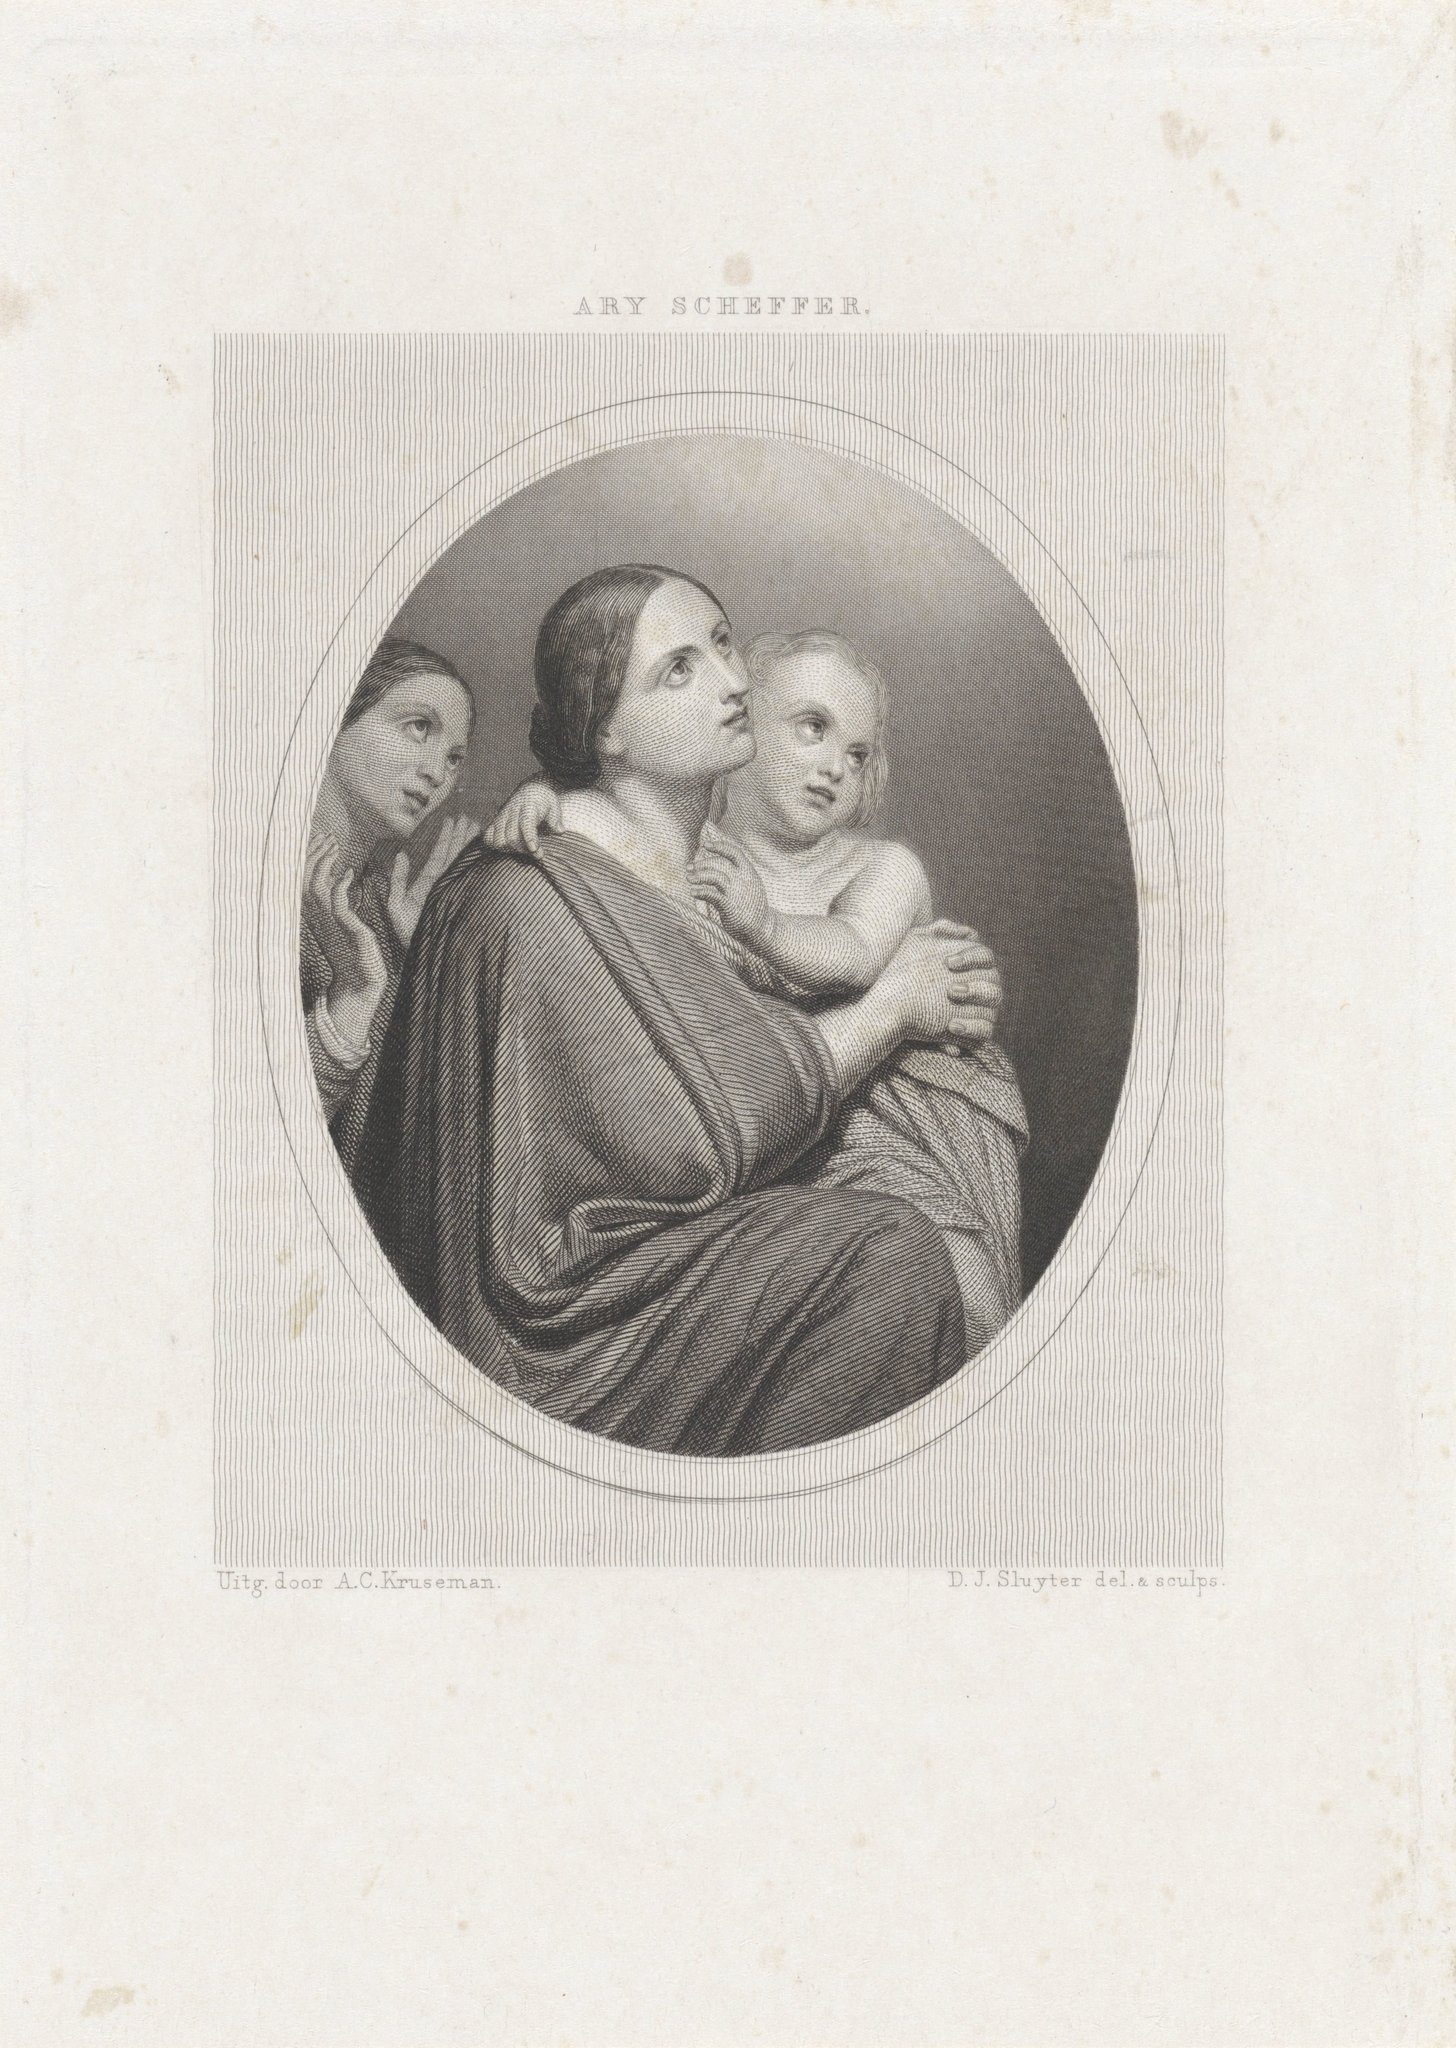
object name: book illustration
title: Vrouw met kind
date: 1852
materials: paper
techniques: etching, engraving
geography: amsterdam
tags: mother and child(ren), woman and child(ren) (family group)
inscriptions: inscription: ‘"Reinen van harte. Uit Aurora 1852.’, collector's mark: Lugt 2228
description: Prent komt voor in: J.I.D. Nepveu en S.J. van den Bergh (reds.). Aurora; jaarboekje voor 1852. Haarlem: A.C. Kruseman, 1852.